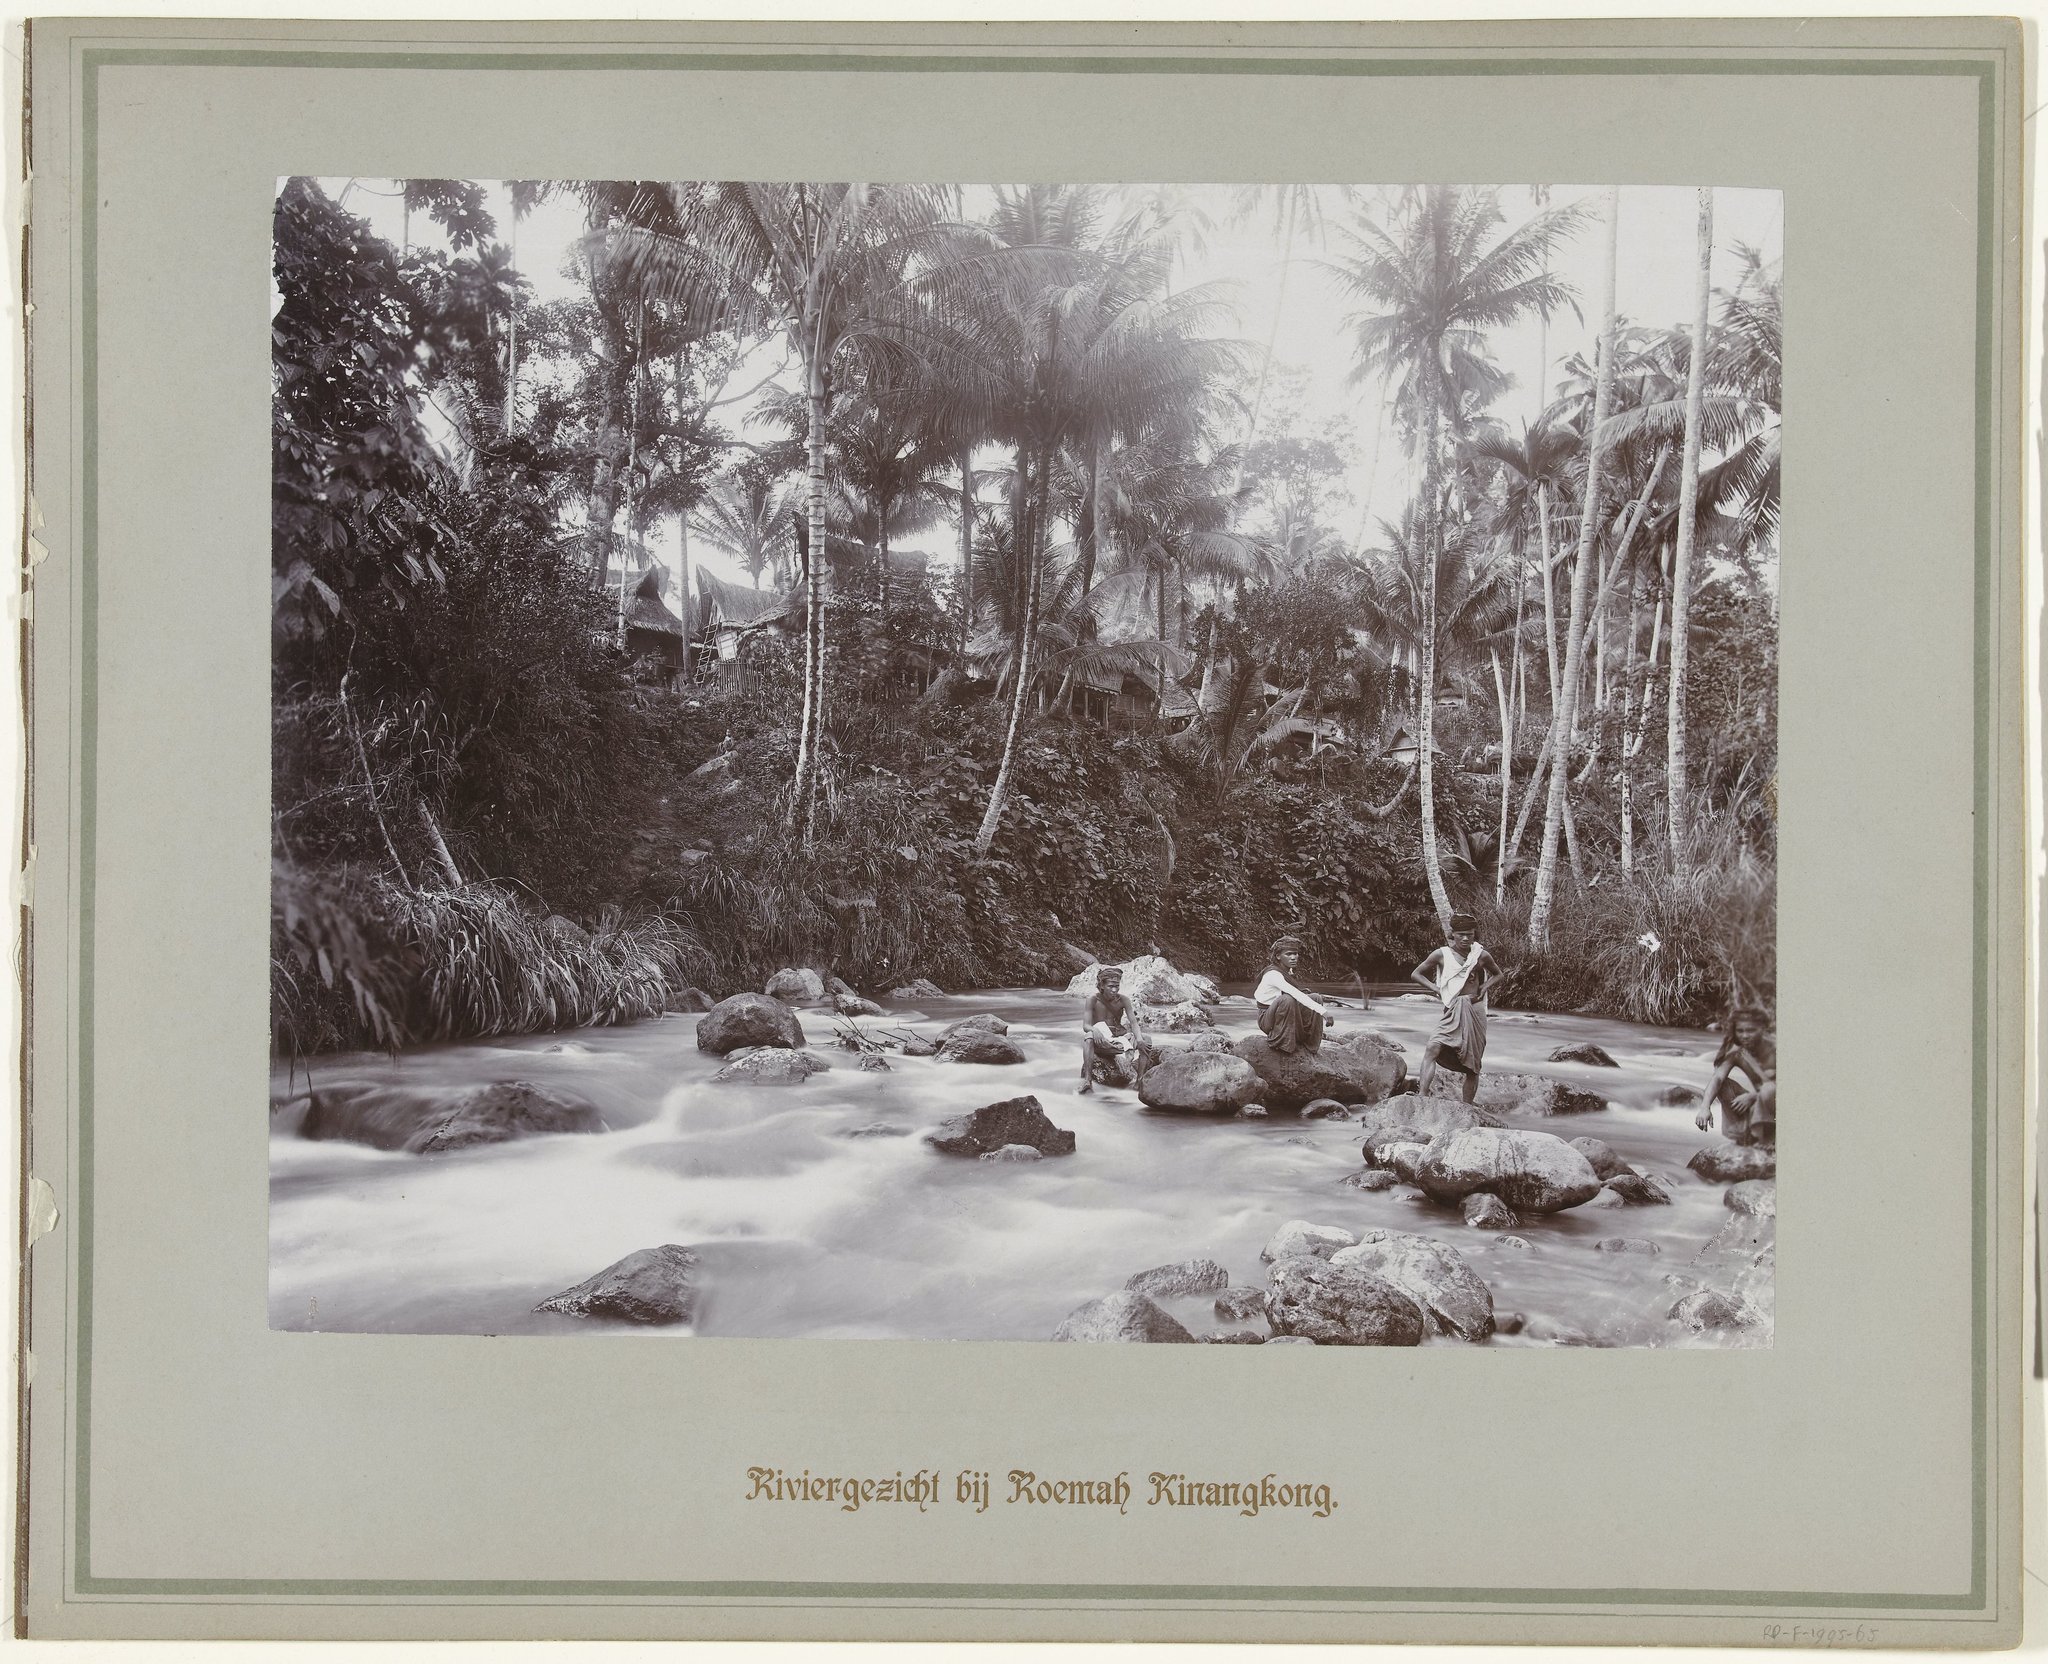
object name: photograph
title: Riviergezicht bij Koemah Kinangkong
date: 1890-1910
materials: cardboard, paper, photographic support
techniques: collodion silver print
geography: medan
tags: human races, peoples and nationalities (other than prehistoric or extinct), indonesia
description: Riviergezicht bij Koemah Kinangkong in Indonesië. Foto geplakt op losgesneden blad uit album, op verso bevindt zich nog een foto uit dezelfde serie.